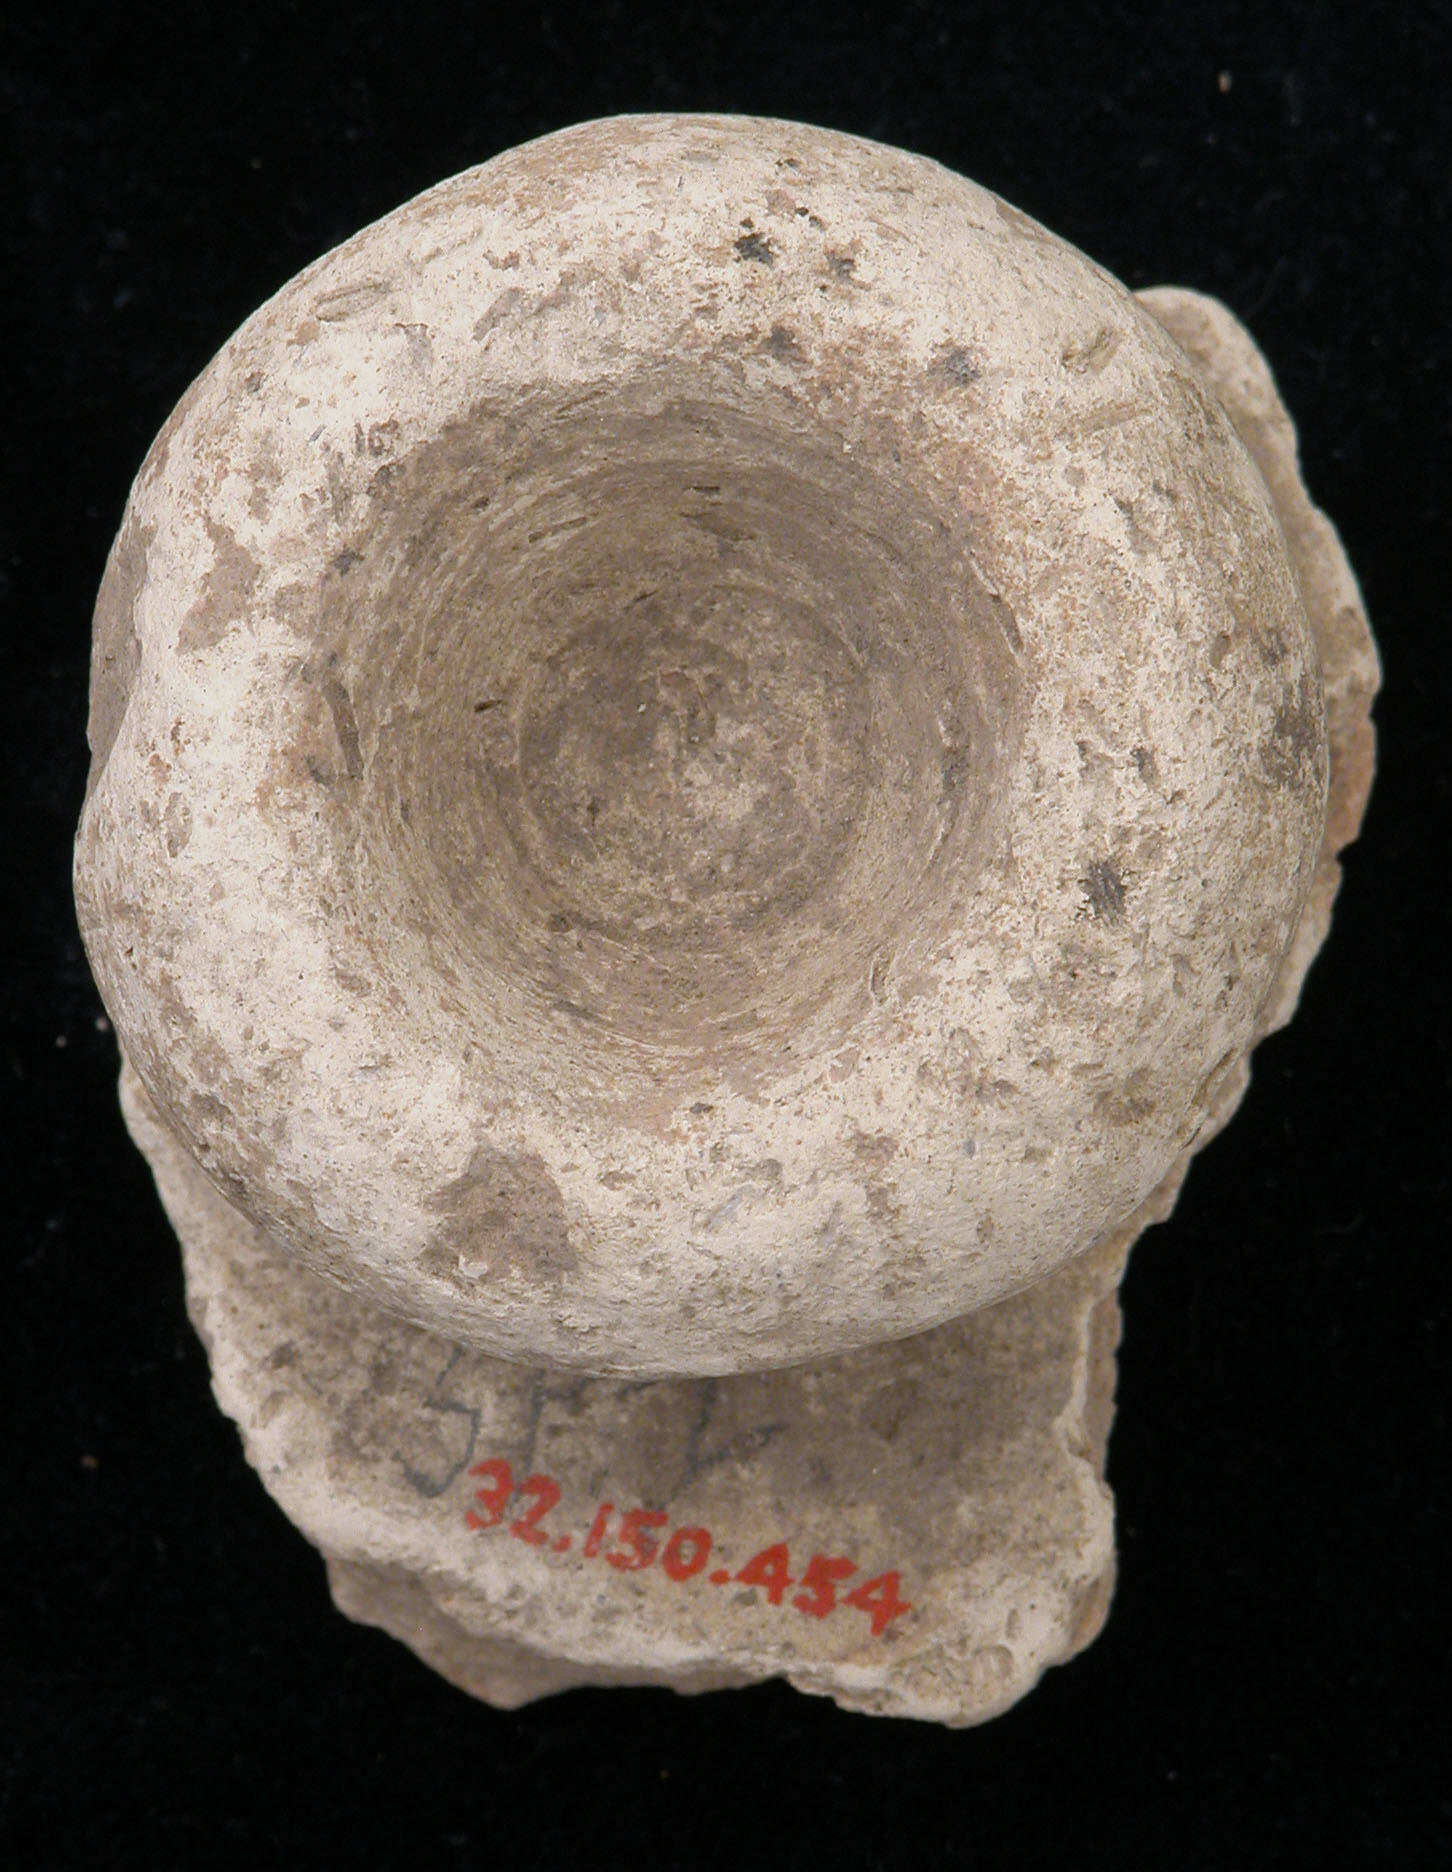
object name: fragment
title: Ceramic Fragment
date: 701-900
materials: earthenware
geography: iraq